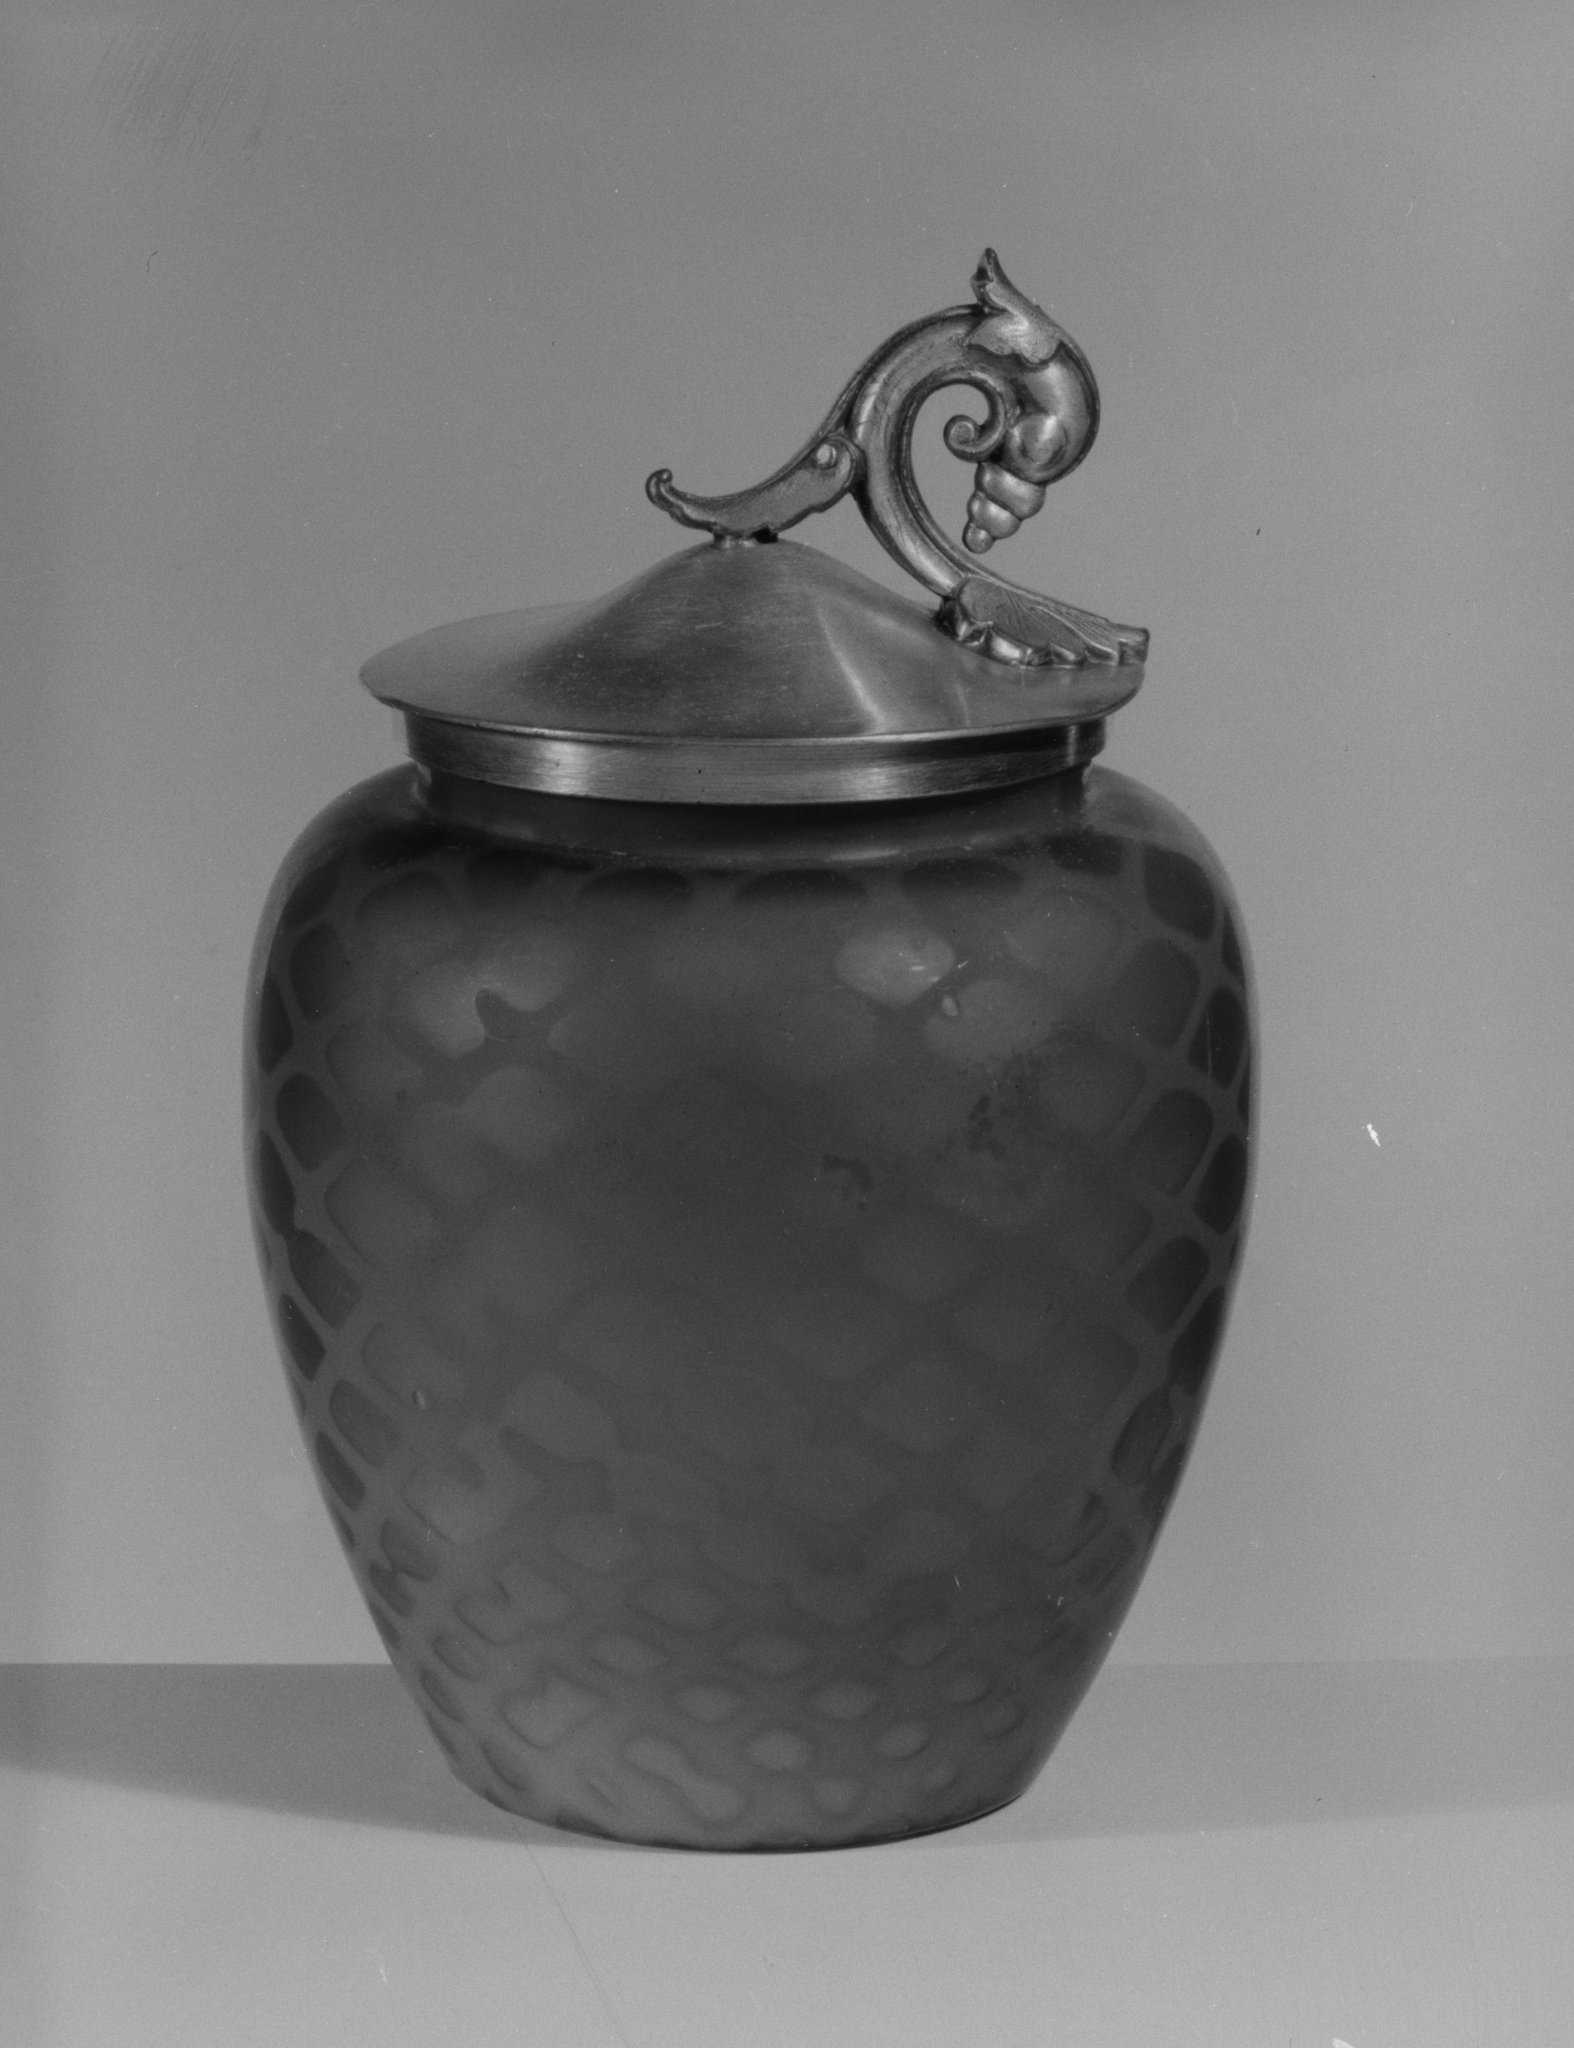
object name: jar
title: Covered Jar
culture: american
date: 1885-1890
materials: glass, textile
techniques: glassblowing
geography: united states